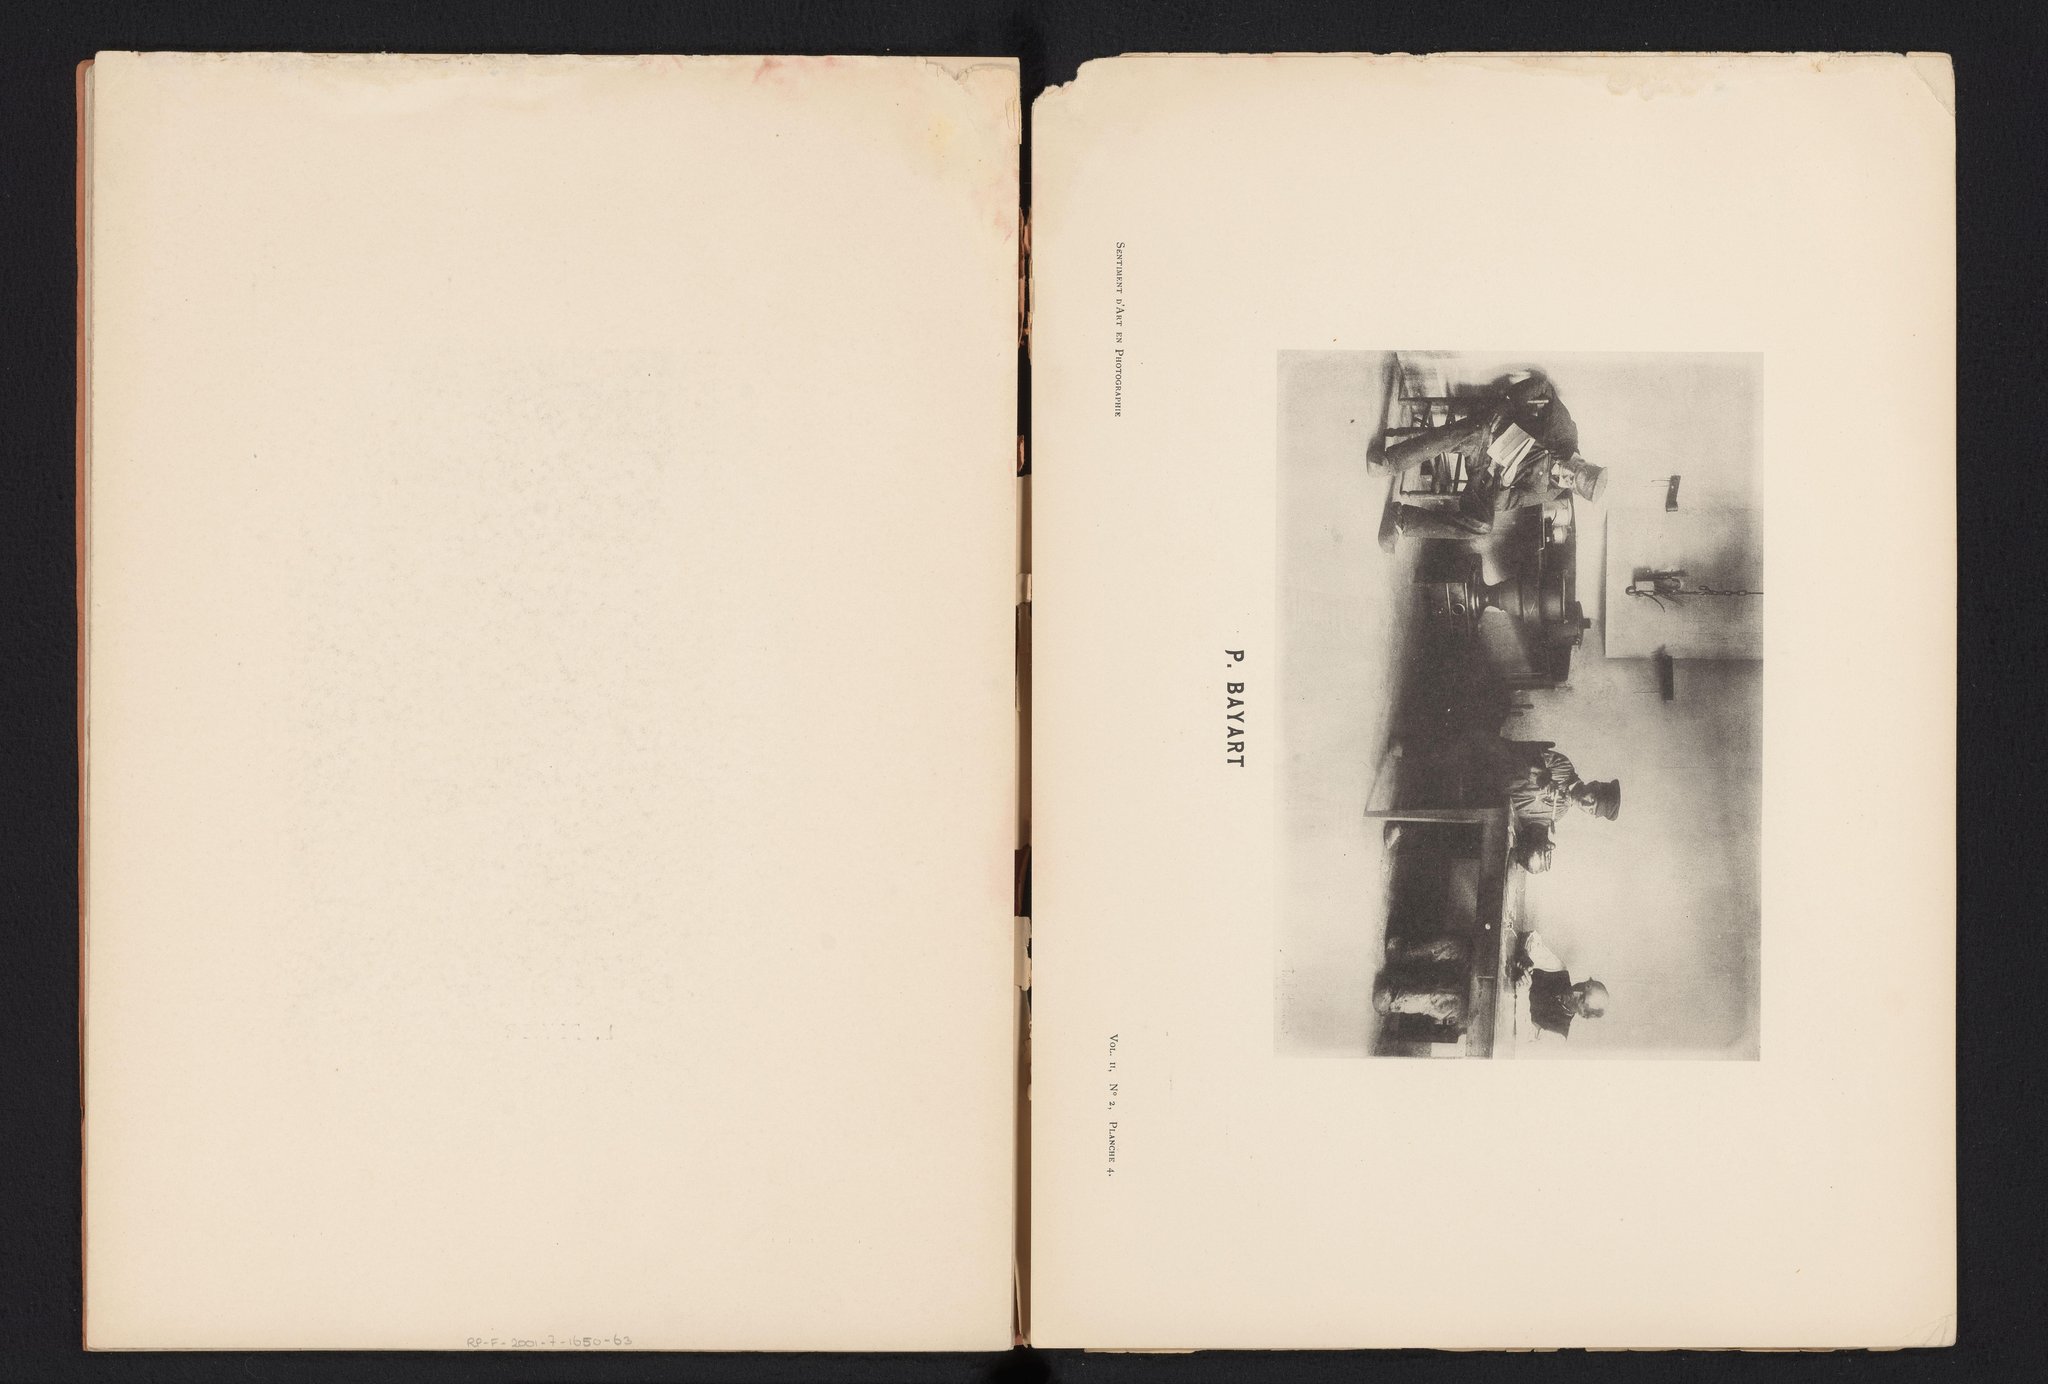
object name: photomechanical print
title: Drie mannen in een keuken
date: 1895-1900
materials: paper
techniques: photograph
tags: adult man (+ three persons), kitchen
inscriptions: number: ‘Vol. II, No 2, Planche 4.’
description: Deze prent maakt deel uit van 8 omslagen met 22 tekstbladen en 89 prenten op losse bladen in en tussen de omslagen.